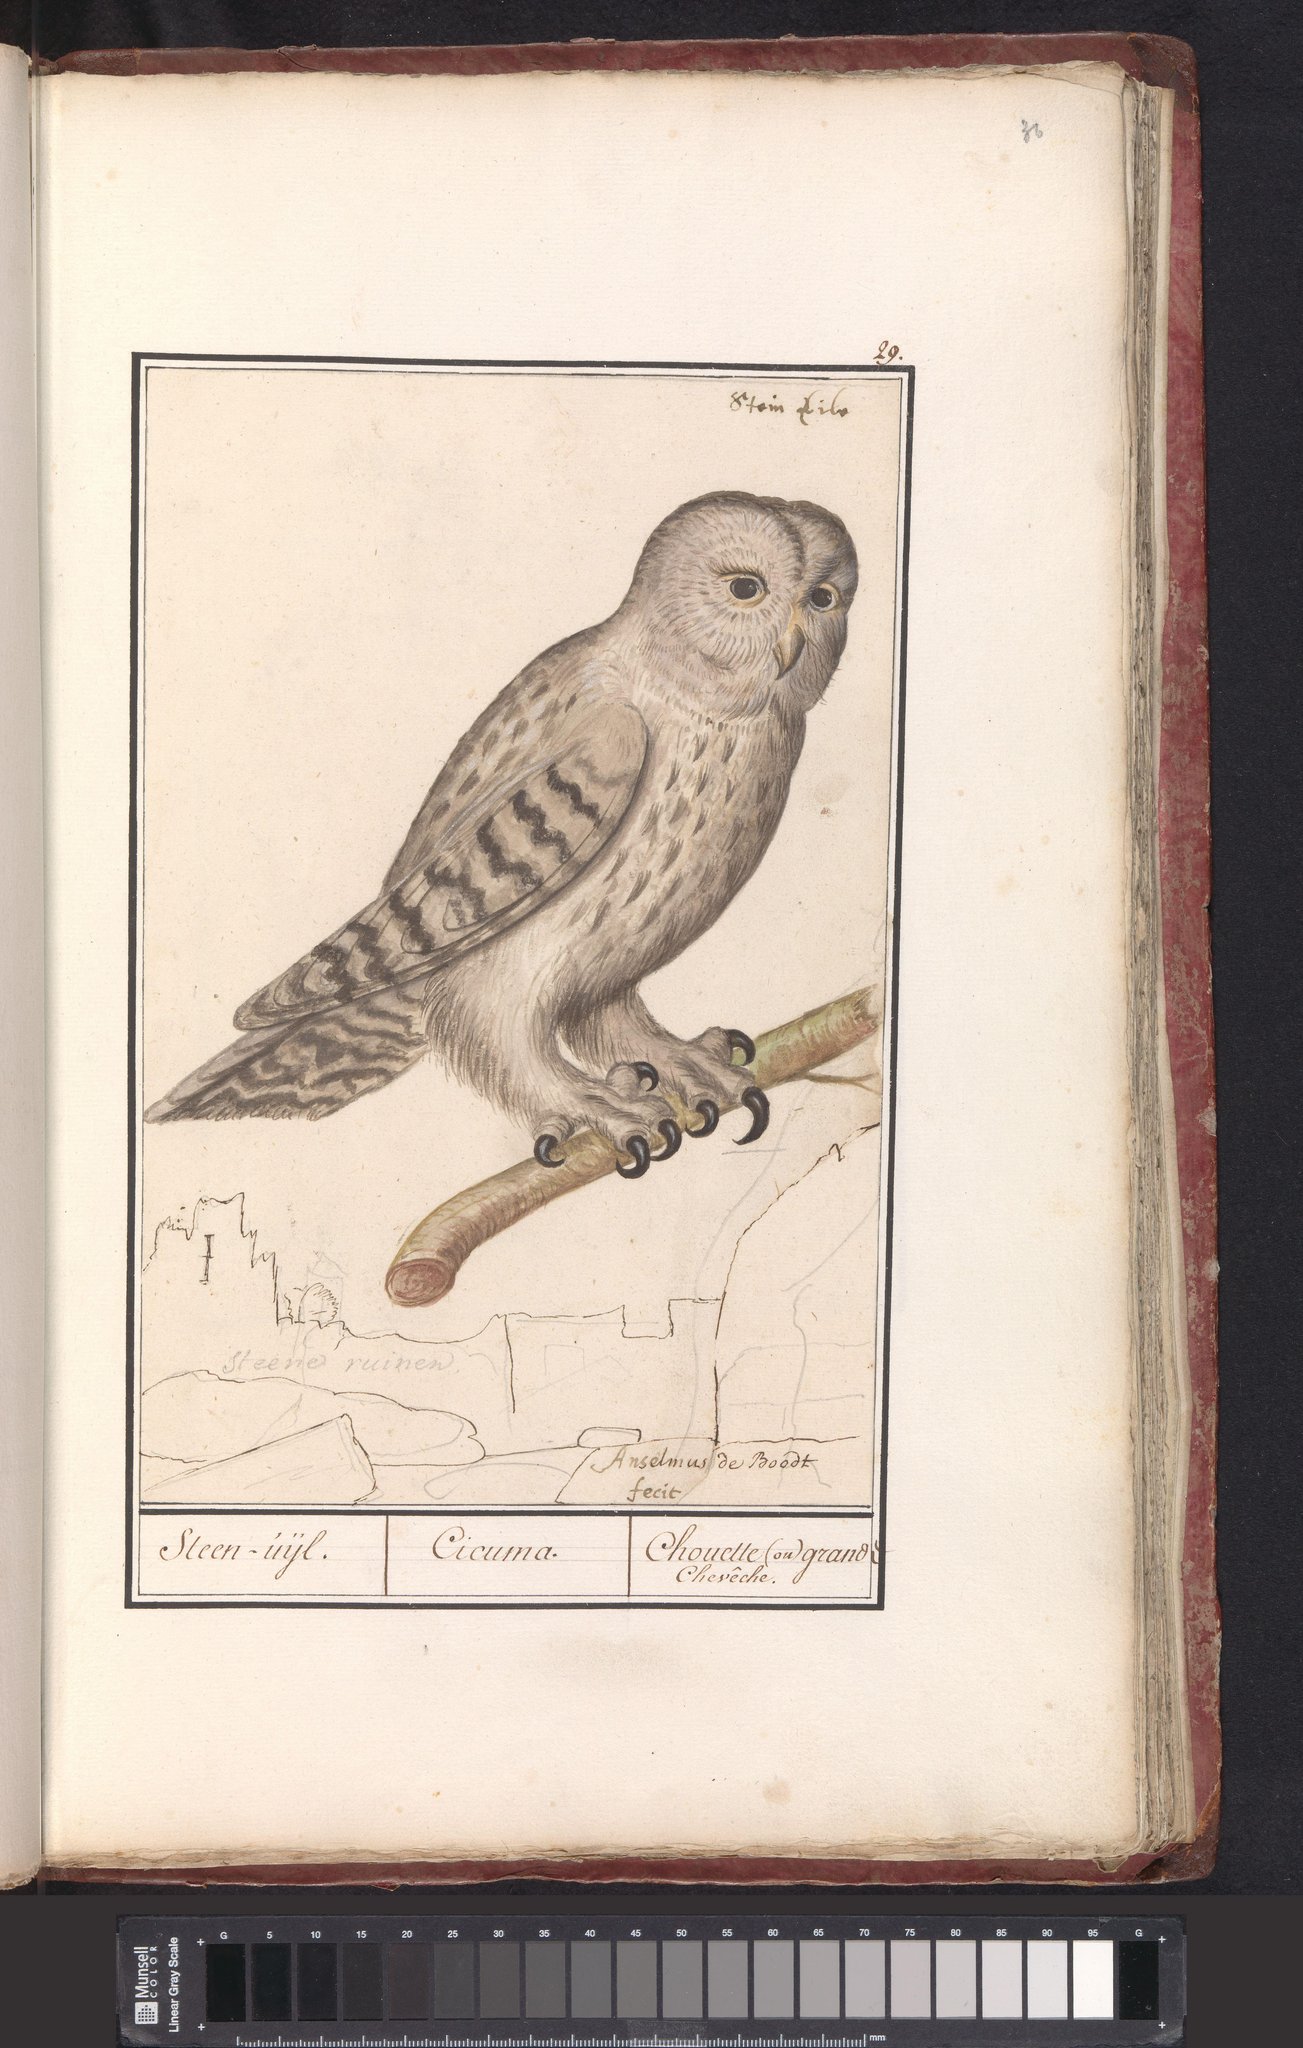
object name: drawing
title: Ural owl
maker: anselmus boëtius de boodt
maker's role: draughtsman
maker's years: 1550-1632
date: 1596-1610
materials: paint, ink, paper, pencil, watercolor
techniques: brush, pen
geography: prague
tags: owls: ural owl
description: Oeraluil. Genummerd rechtsboven: 29. Rechtsboven de Latijnse naam. Onderdeel van het eerste album met tekeningen van vogels. Derde van twaalf albums met tekeningen van dieren, vogels en planten bekend rond 1600, gemaakt in opdracht van keizer Rudolf II. Met toelichting in Nederlands, Latijn en Frans.